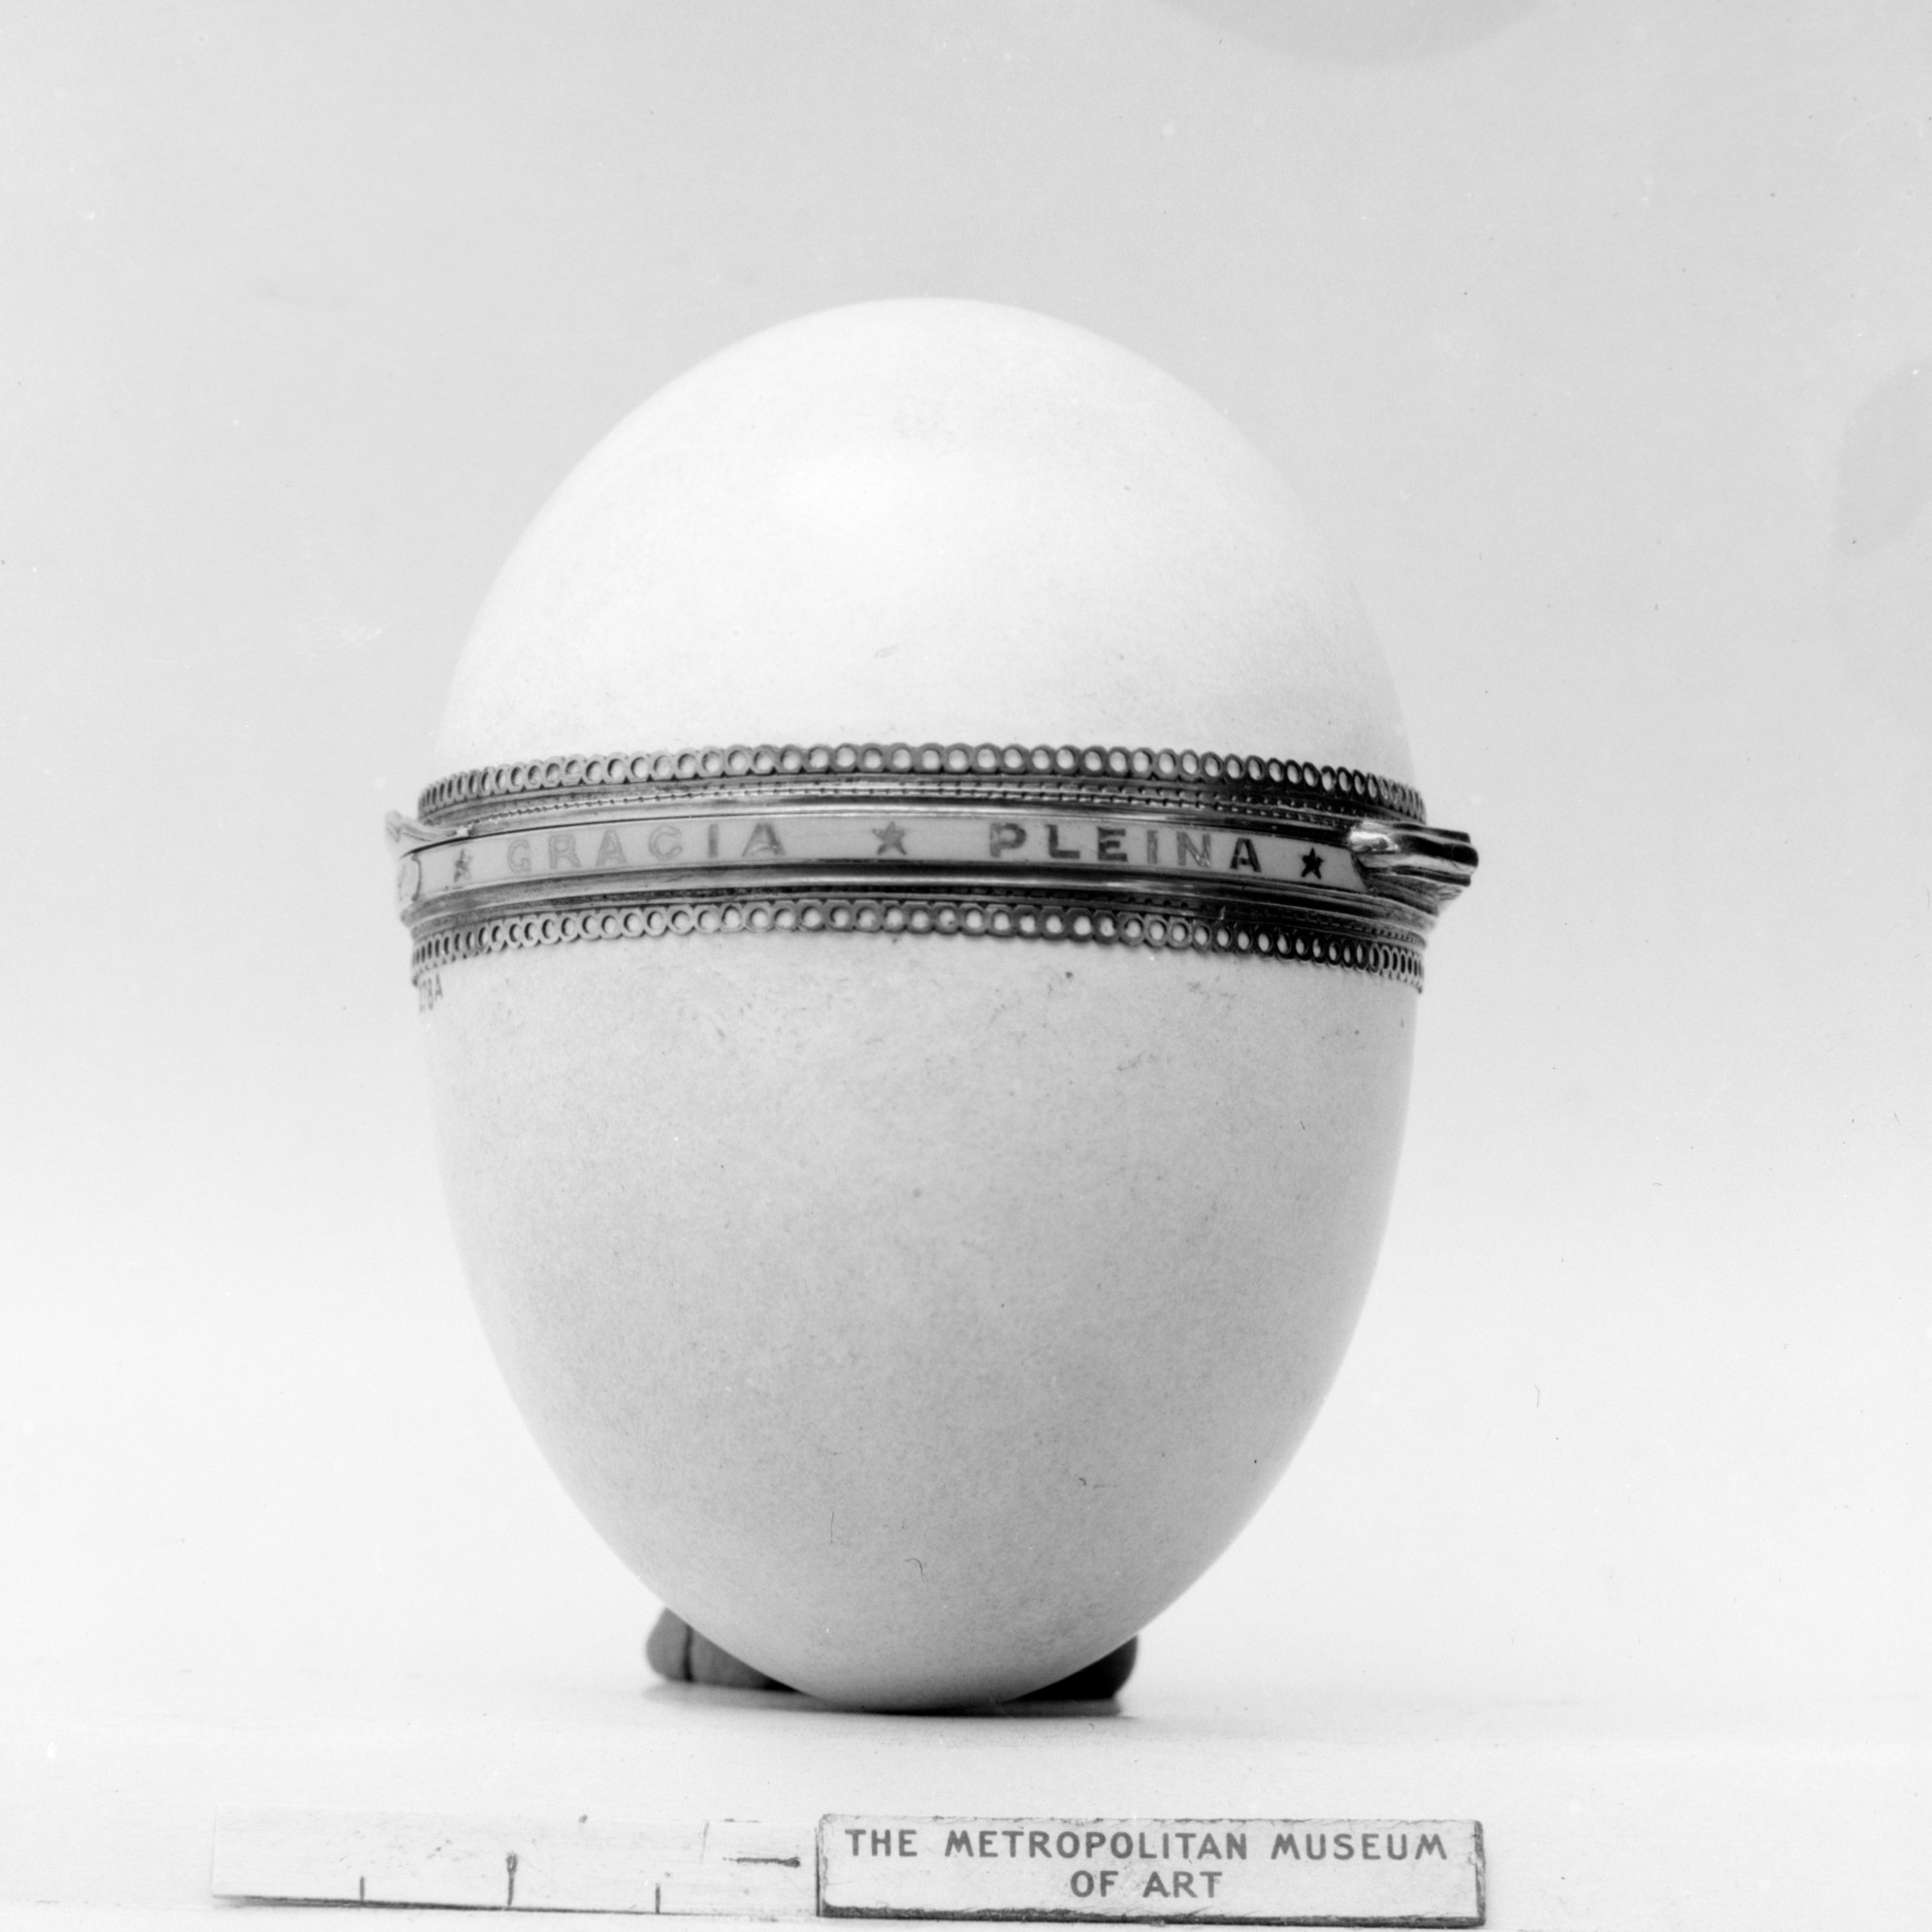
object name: nécessaire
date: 1801-1900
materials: enamel, gold, pearl